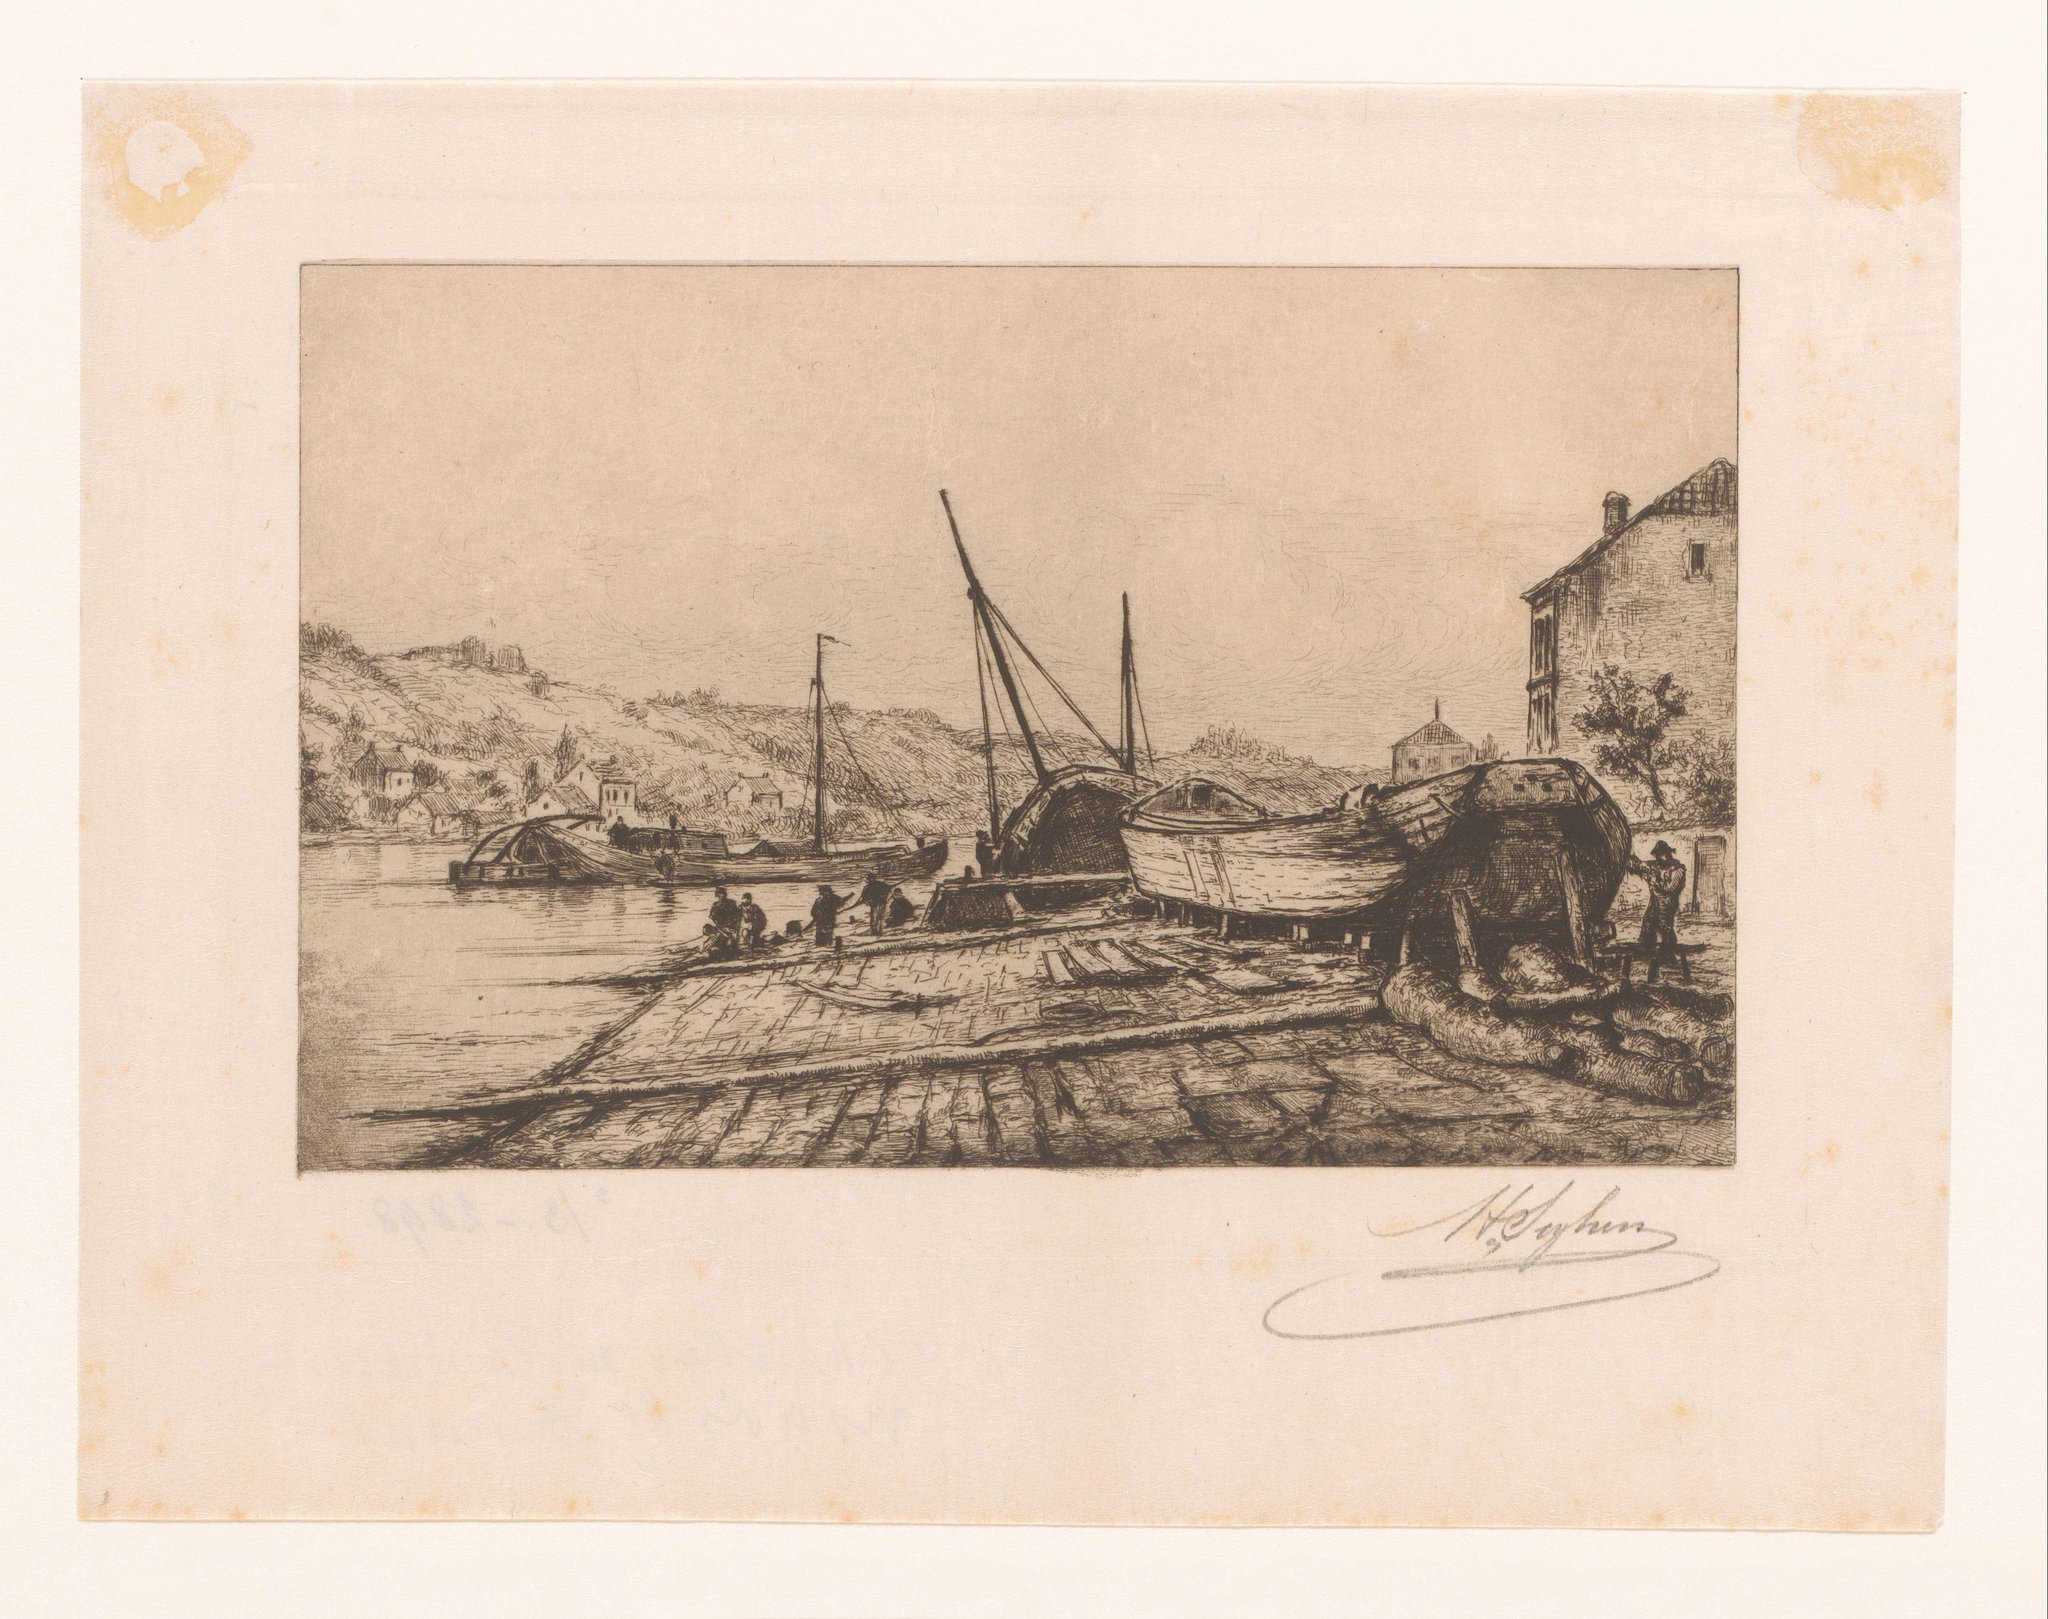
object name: print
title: Aangemeerde zeilschepen in een haven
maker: henri seghers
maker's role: draughtsman, painter, print maker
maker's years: 1848-1919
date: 1880-1890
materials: paper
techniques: etching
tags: harbour, sailing-ship, sailing-boat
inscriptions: collector's mark: Lugt 2228